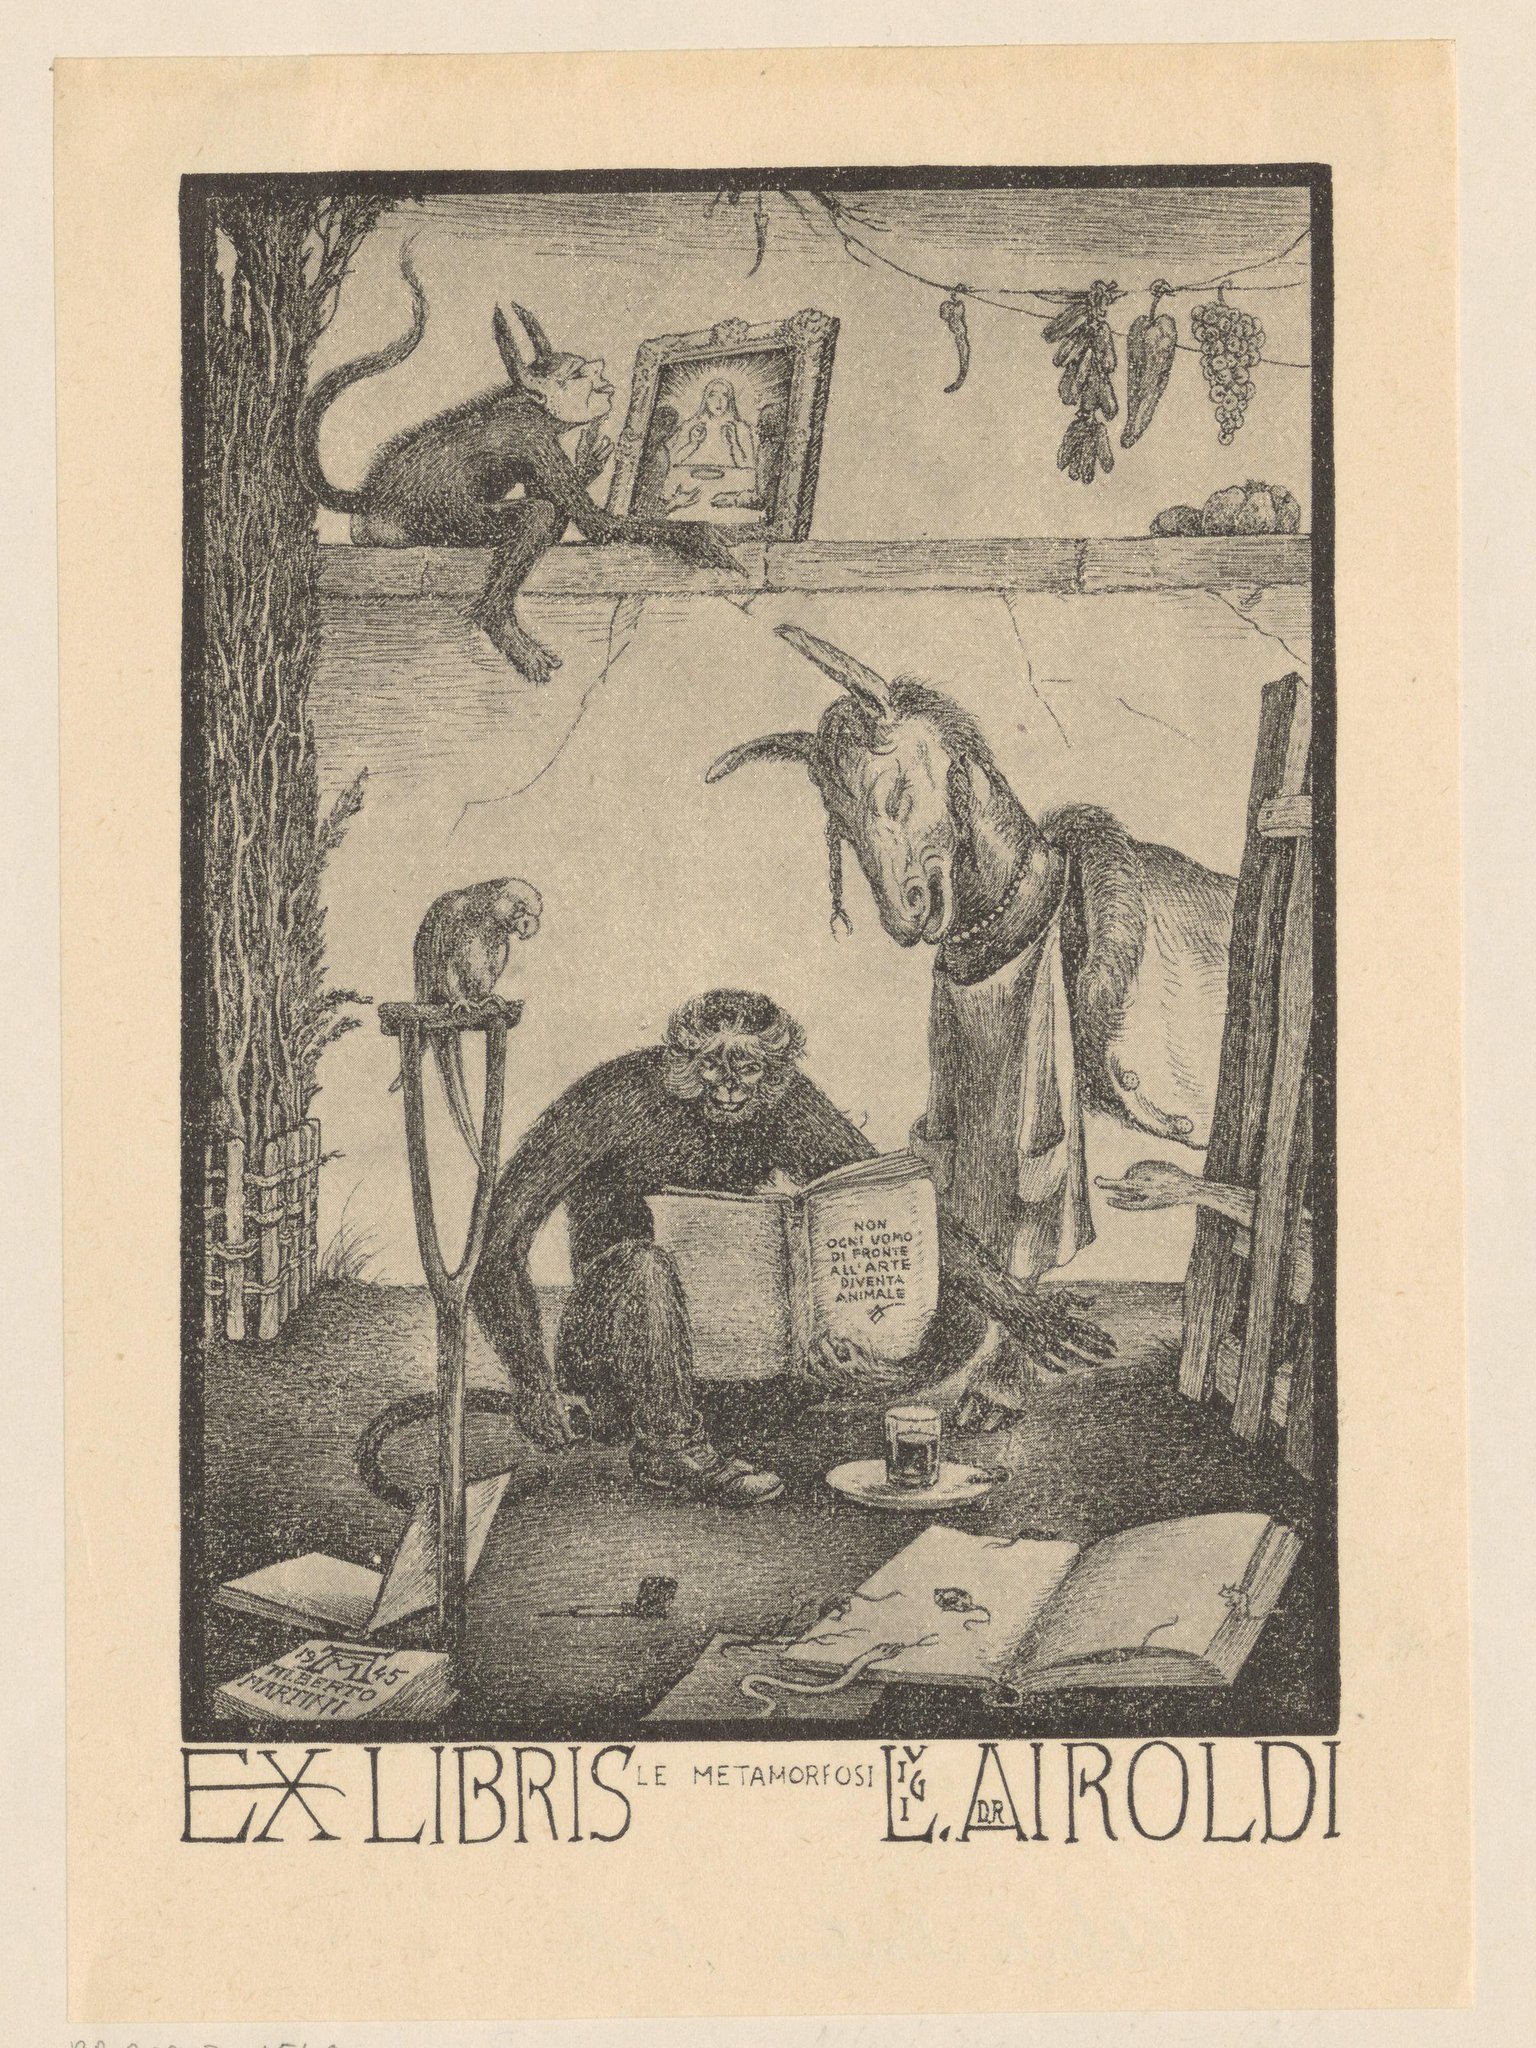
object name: photomechanical print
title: Ex libris van Luigi Airoldi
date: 1945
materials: paper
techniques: autotype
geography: italy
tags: reading, ass, donkey, monkeys, apes, book, metamorphoses ~ classical mythology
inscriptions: date